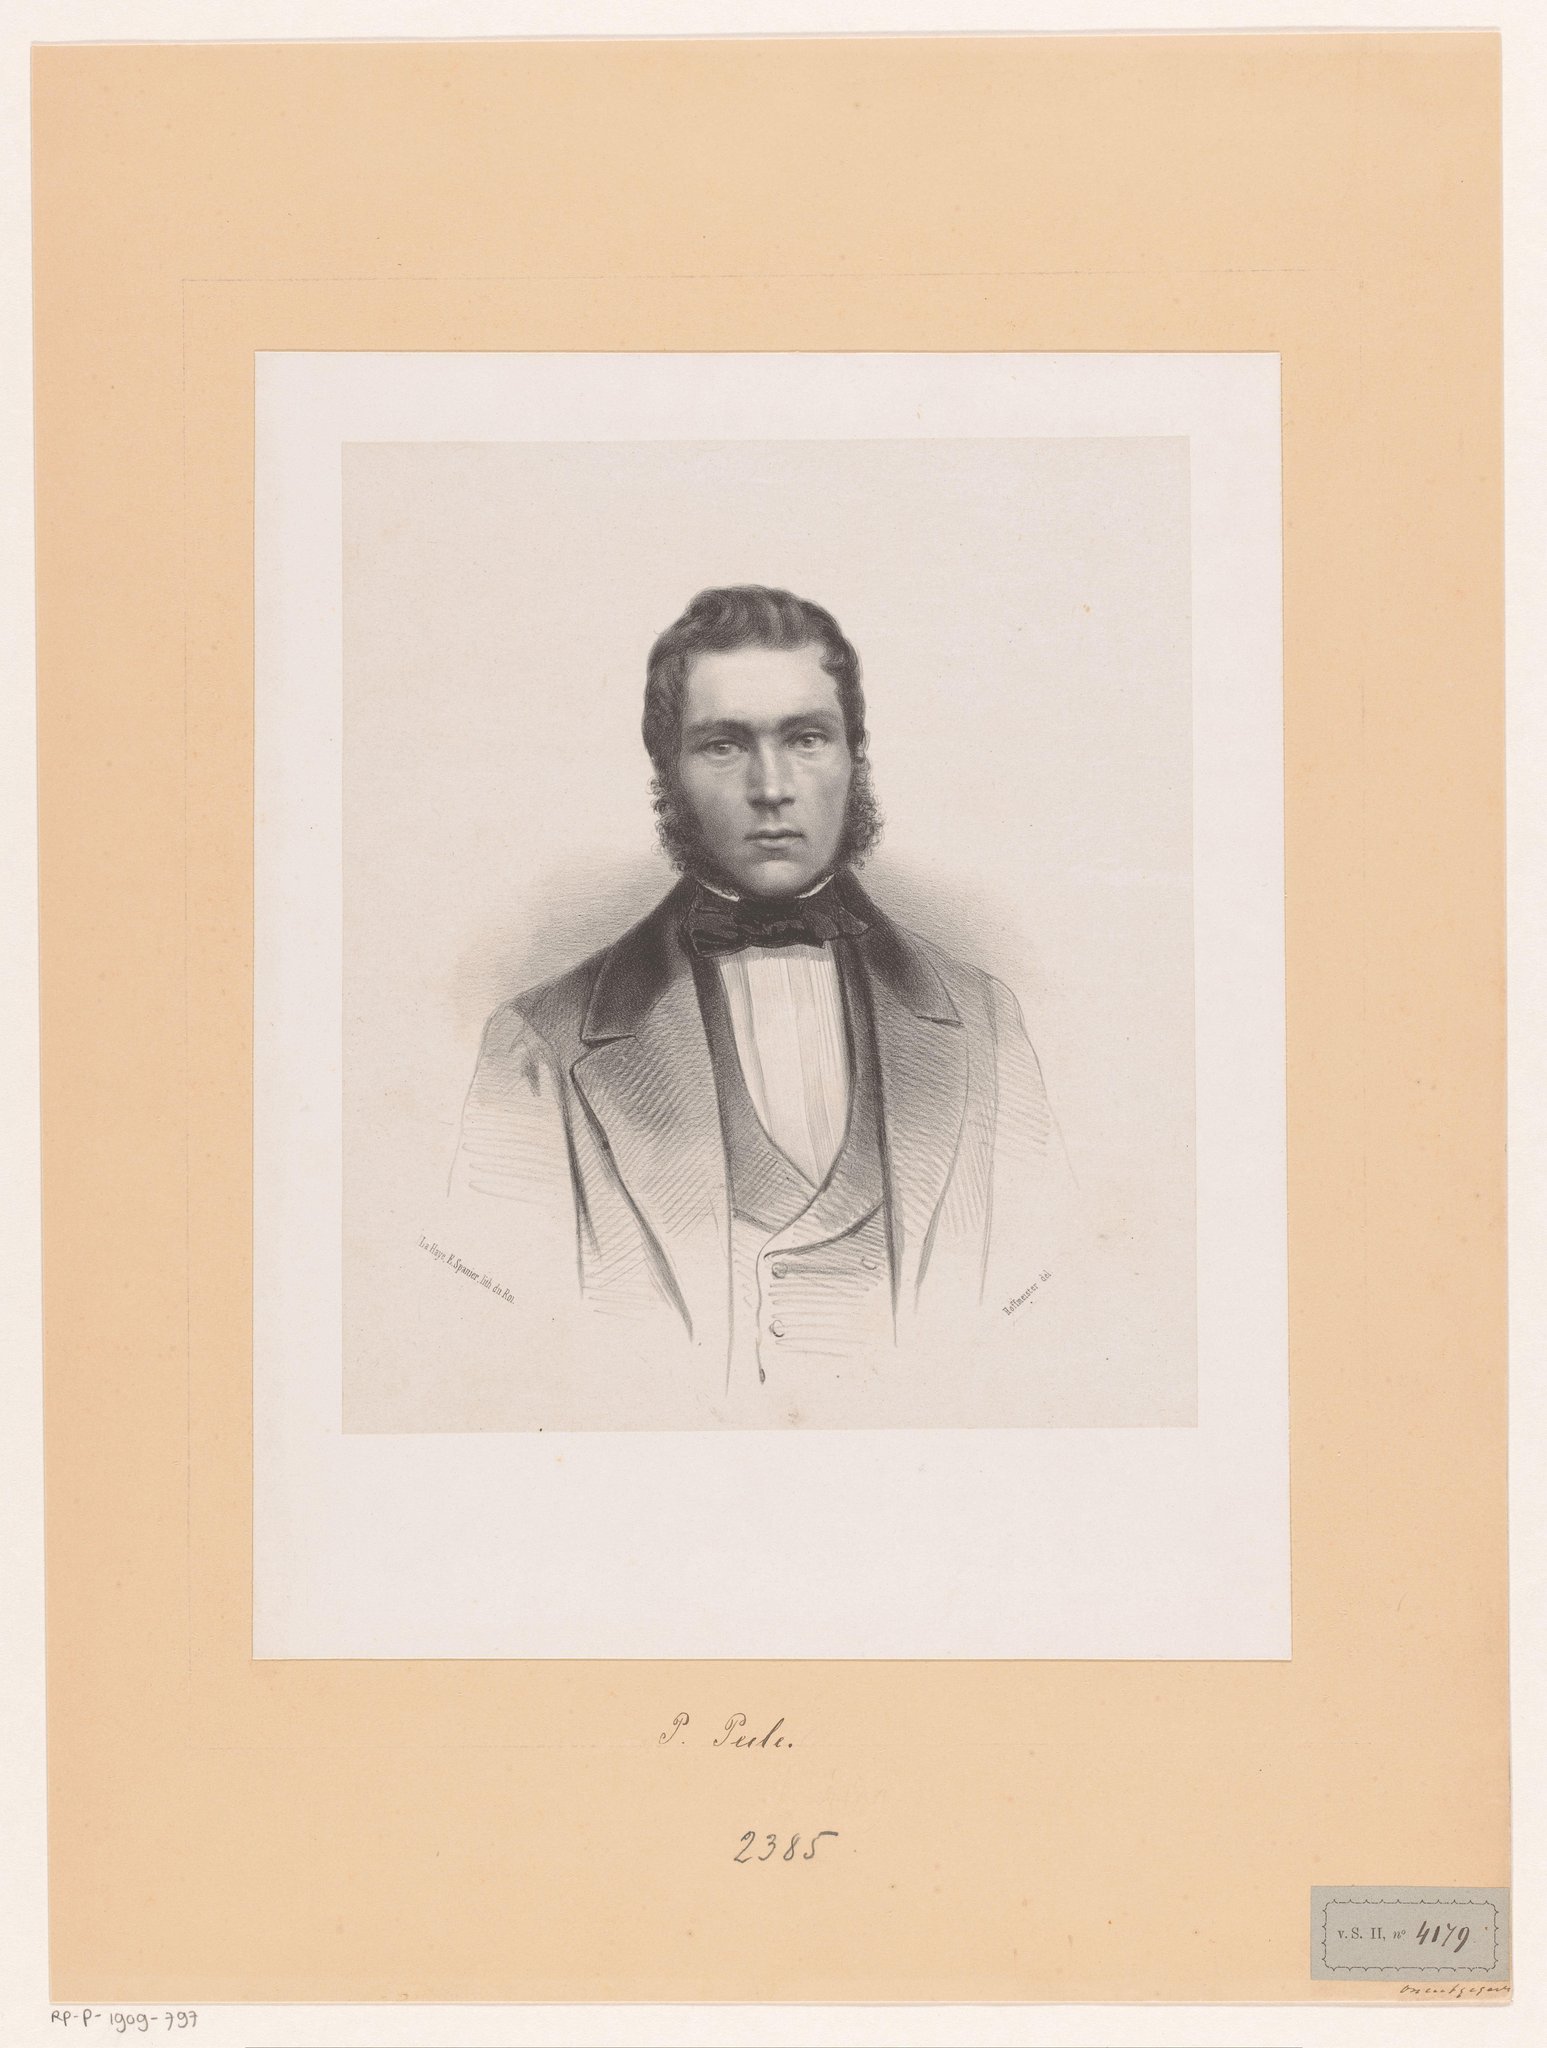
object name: print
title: Portret van P. Peele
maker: johan hendrik hoffmeister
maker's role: print maker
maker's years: 1823-1904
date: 1851-1883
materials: paper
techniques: lithograph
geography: netherlands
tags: sideburns, historical persons (+ (full) bust portrait)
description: De geportretteerde heeft lange borstelige bakkebaarden